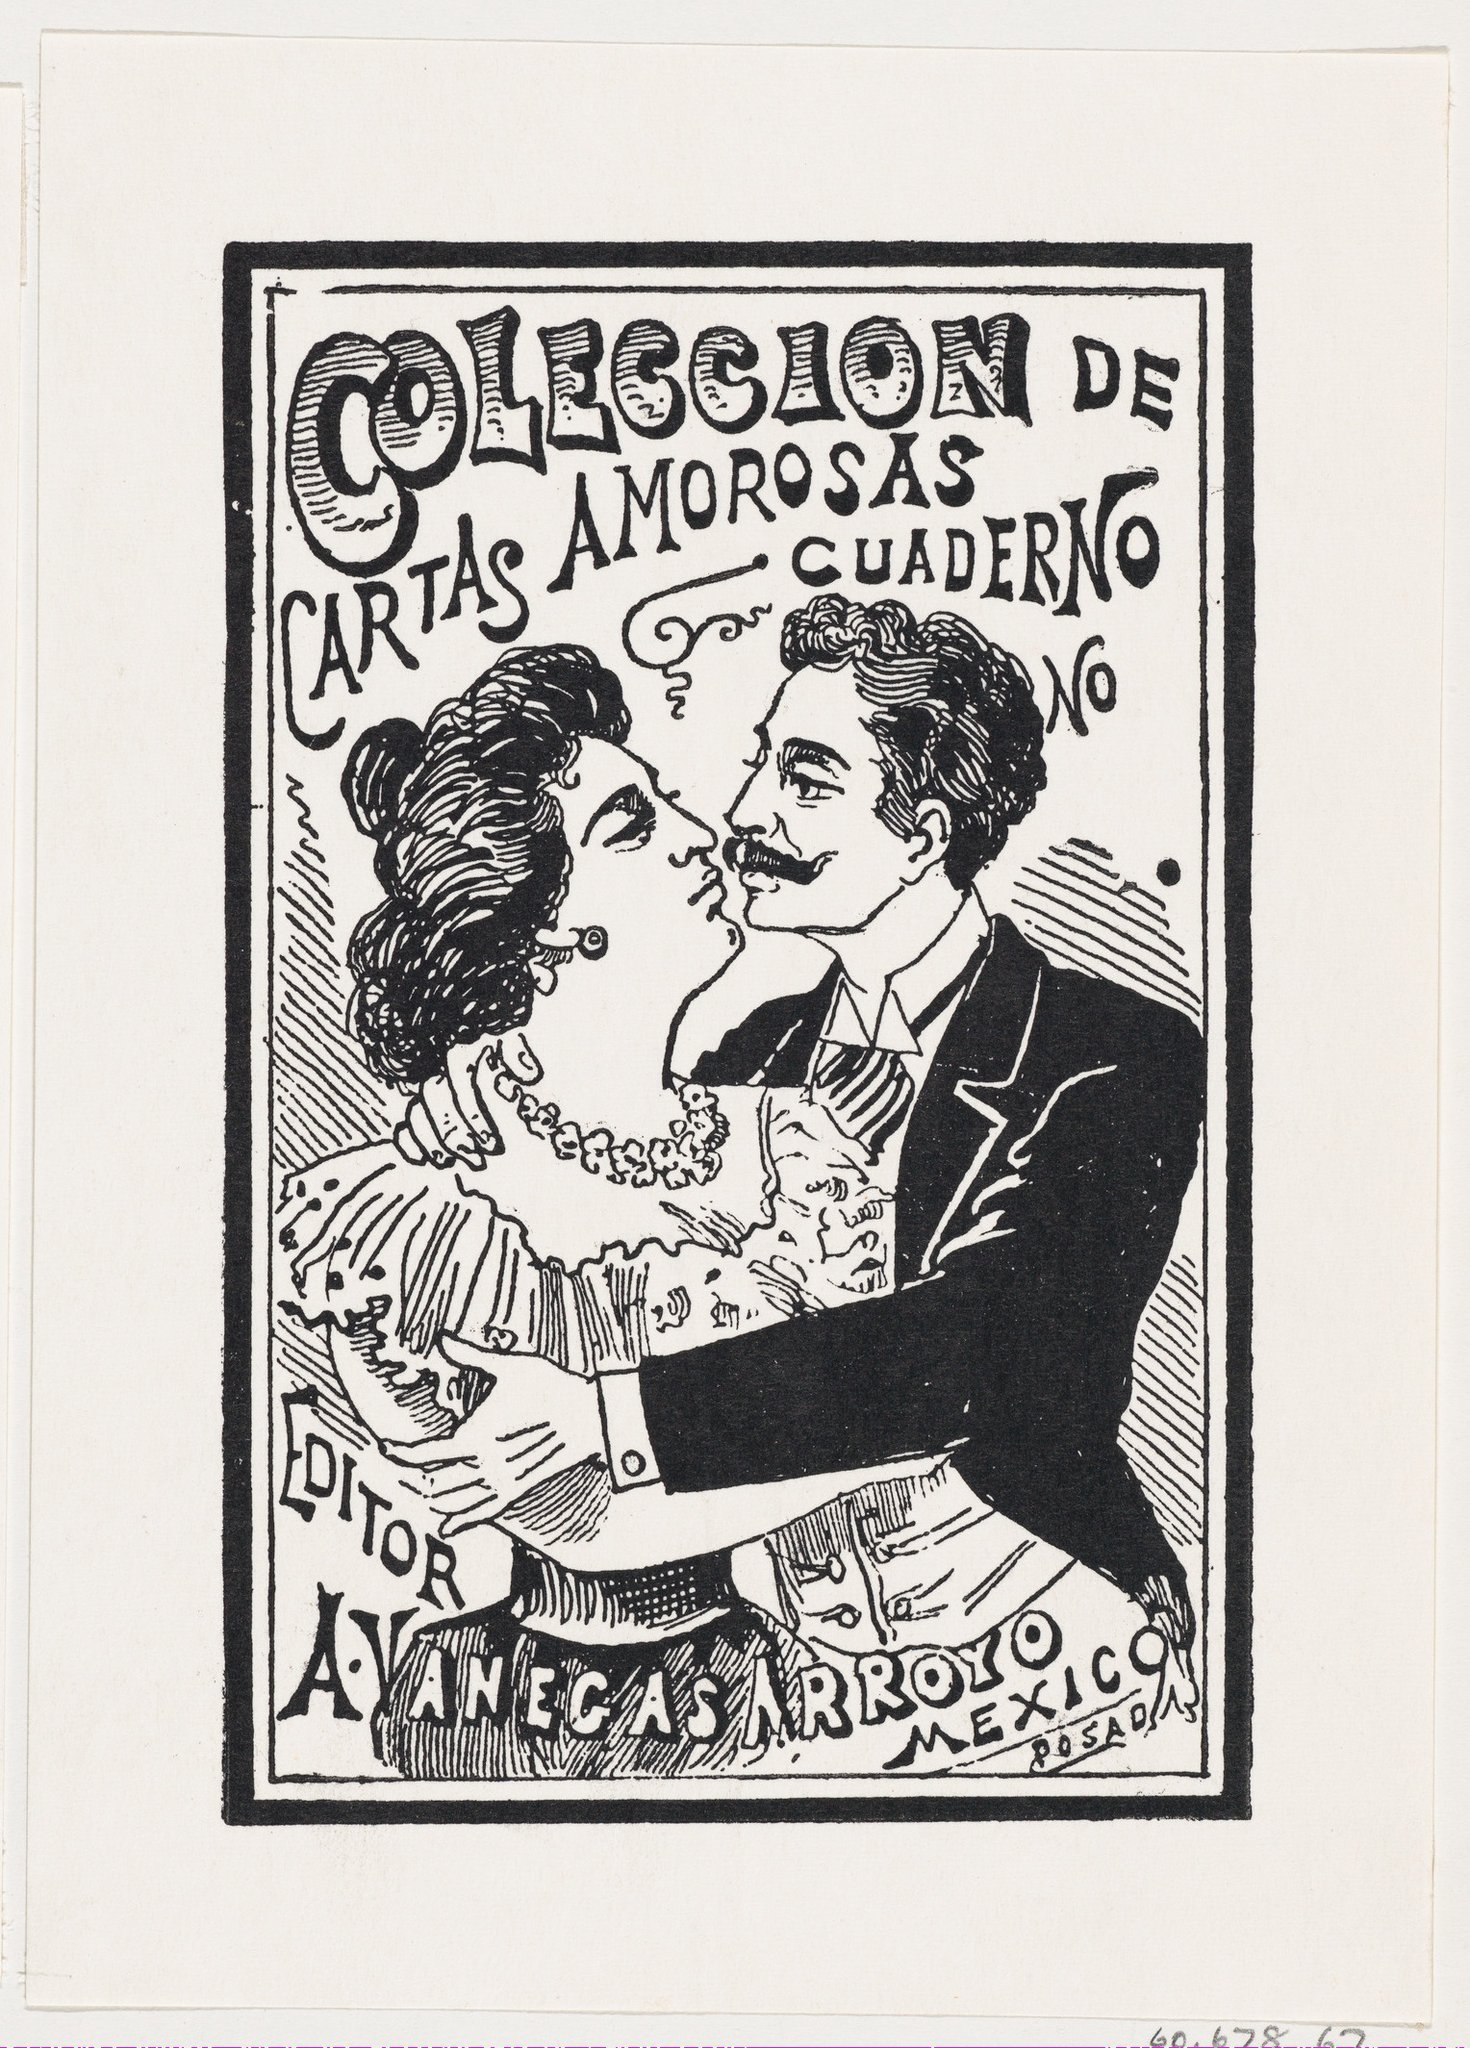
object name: print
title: A couple in a passionate embrace, illustration for 'Coleccion de Cartas Amorosas'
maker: josé guadalupe posada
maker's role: artist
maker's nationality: mexican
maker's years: 1852-1913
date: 1880-1910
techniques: lithography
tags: couples,men,women